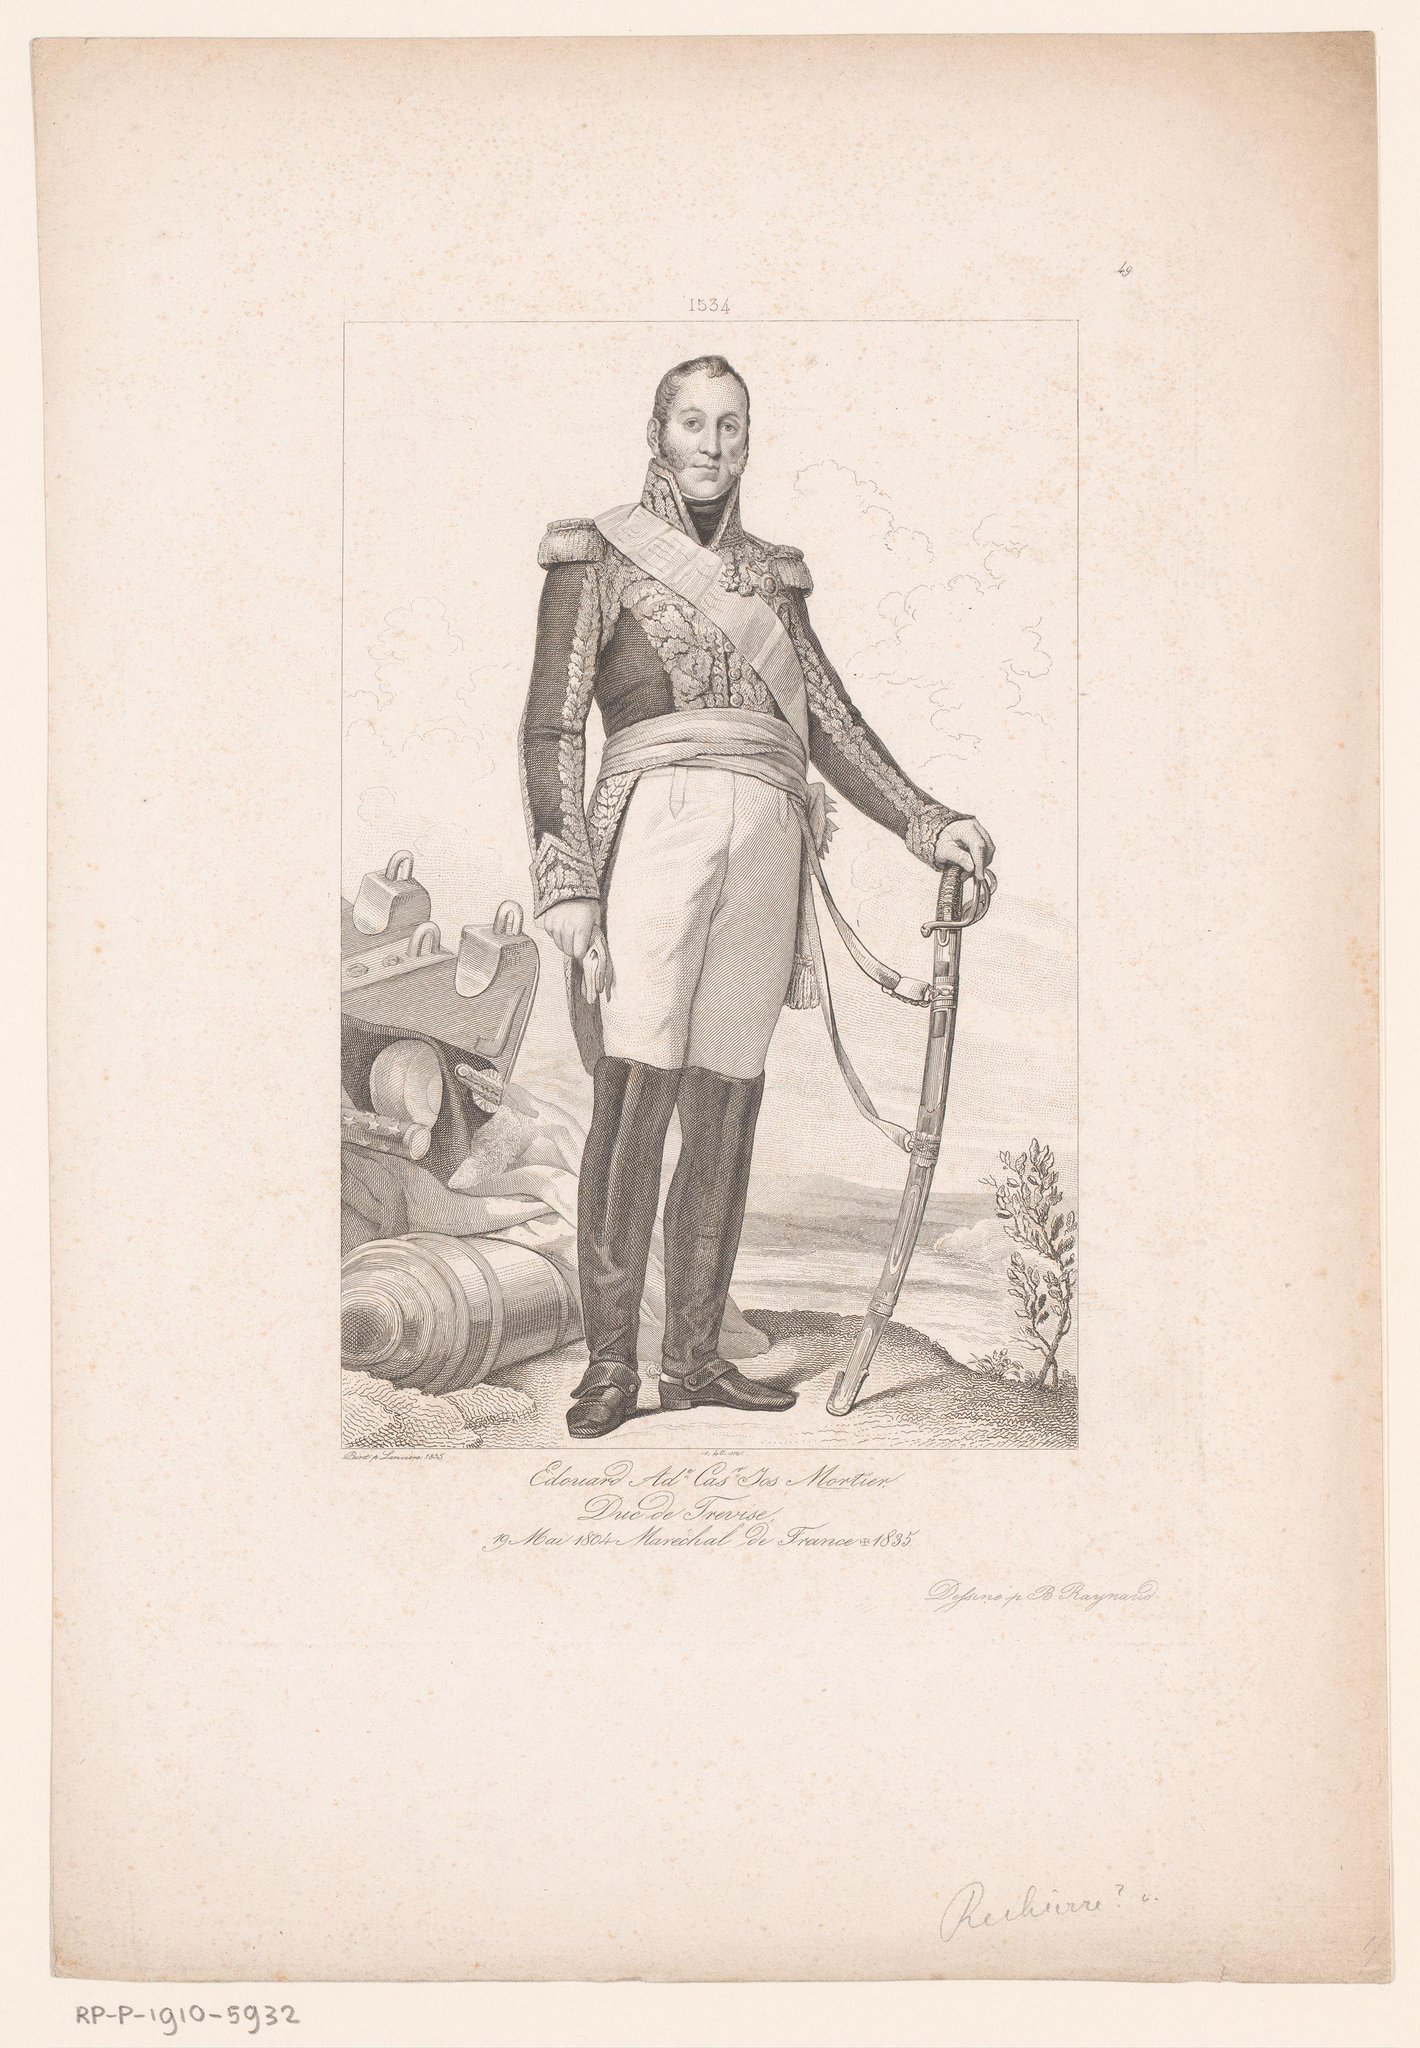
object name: book illustration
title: Edouard Ade Casr Jos Mortier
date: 1838-1841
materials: paper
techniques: etching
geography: paris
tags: paris, commander-in-chief, general, marshal, historical persons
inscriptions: collector's mark: Lugt 2228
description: Prent uit: s.n. Galeries historiques de Versailles. Parijs: Charles Gavard, 1838-1841.